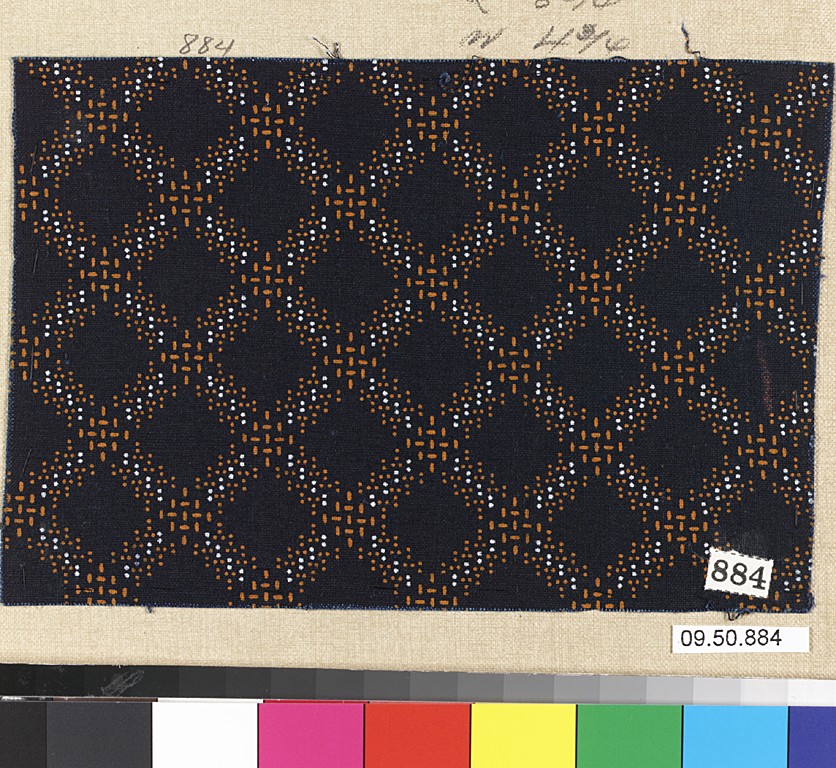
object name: piece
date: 1801-1900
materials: cotton